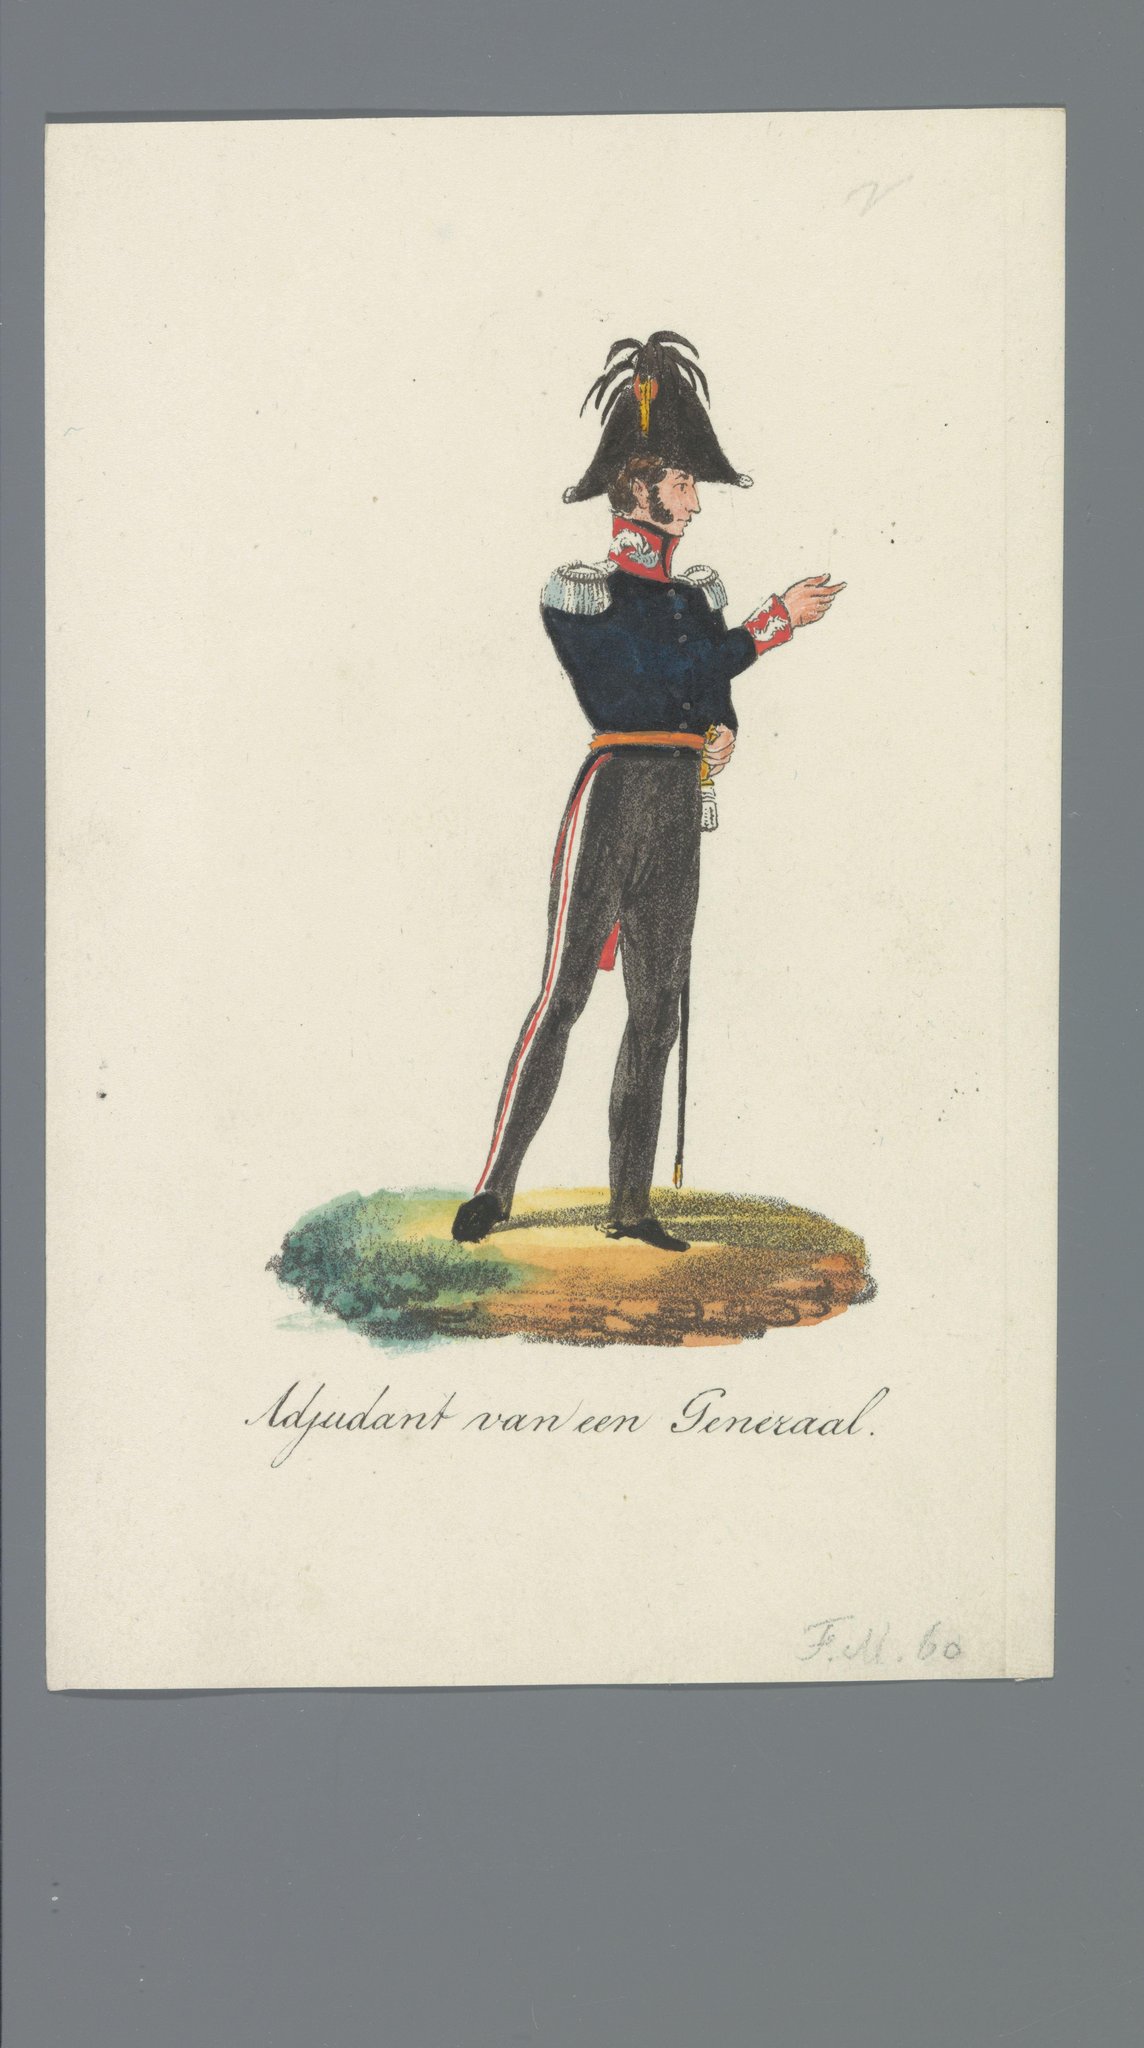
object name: costume print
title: Nederlandse militaire uniformen in de jaren 1830-1832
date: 1835-1850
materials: paper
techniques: hand coloring, lithograph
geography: utrecht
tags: (military) uniforms, clothes, costume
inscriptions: collector's mark: Lugt 2228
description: Staande adjudant van een generaal. Lid van de Generale Staf. Onderdeel van een serie van 157 losse bladen met Nederlandse militaire uniformen in de jaren 1830-1832.